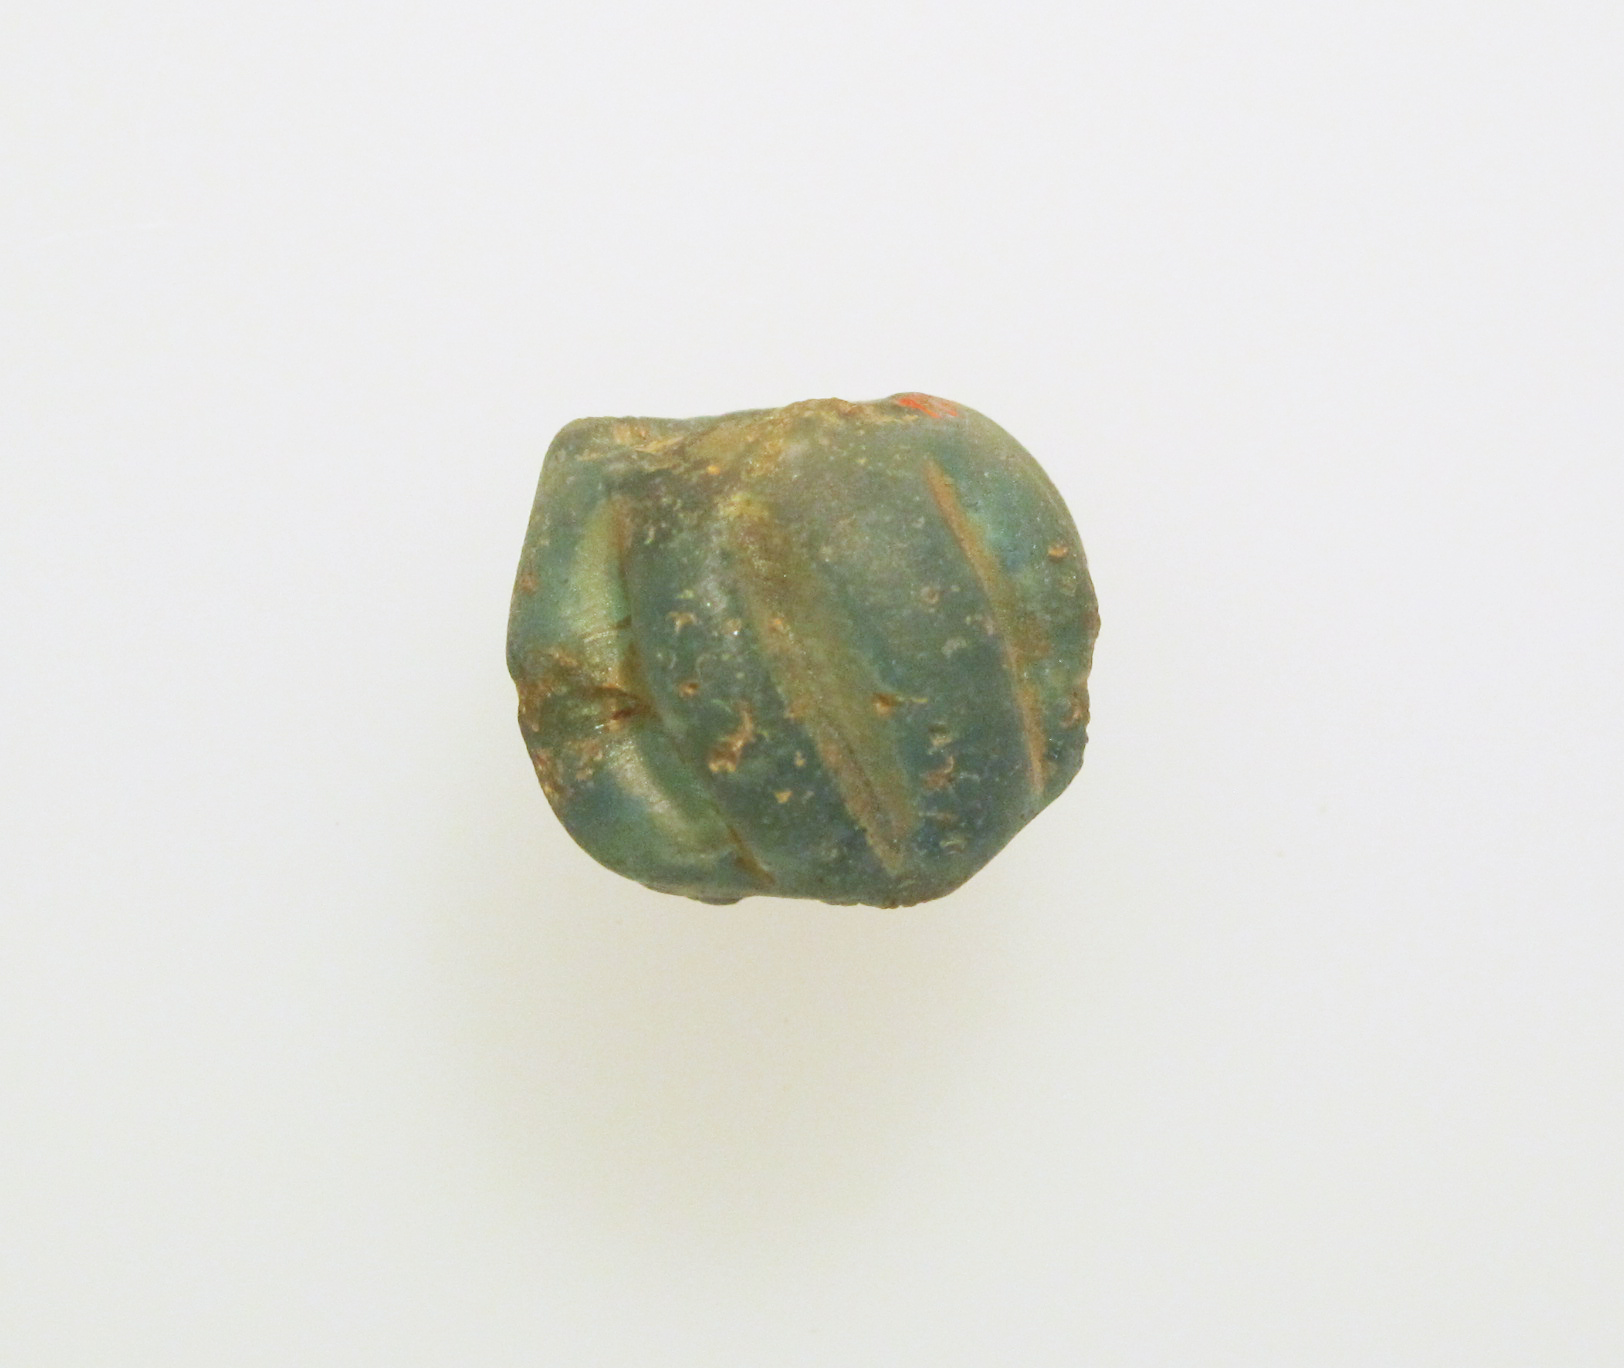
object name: bead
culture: roman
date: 670 BCE-330 CE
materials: glass